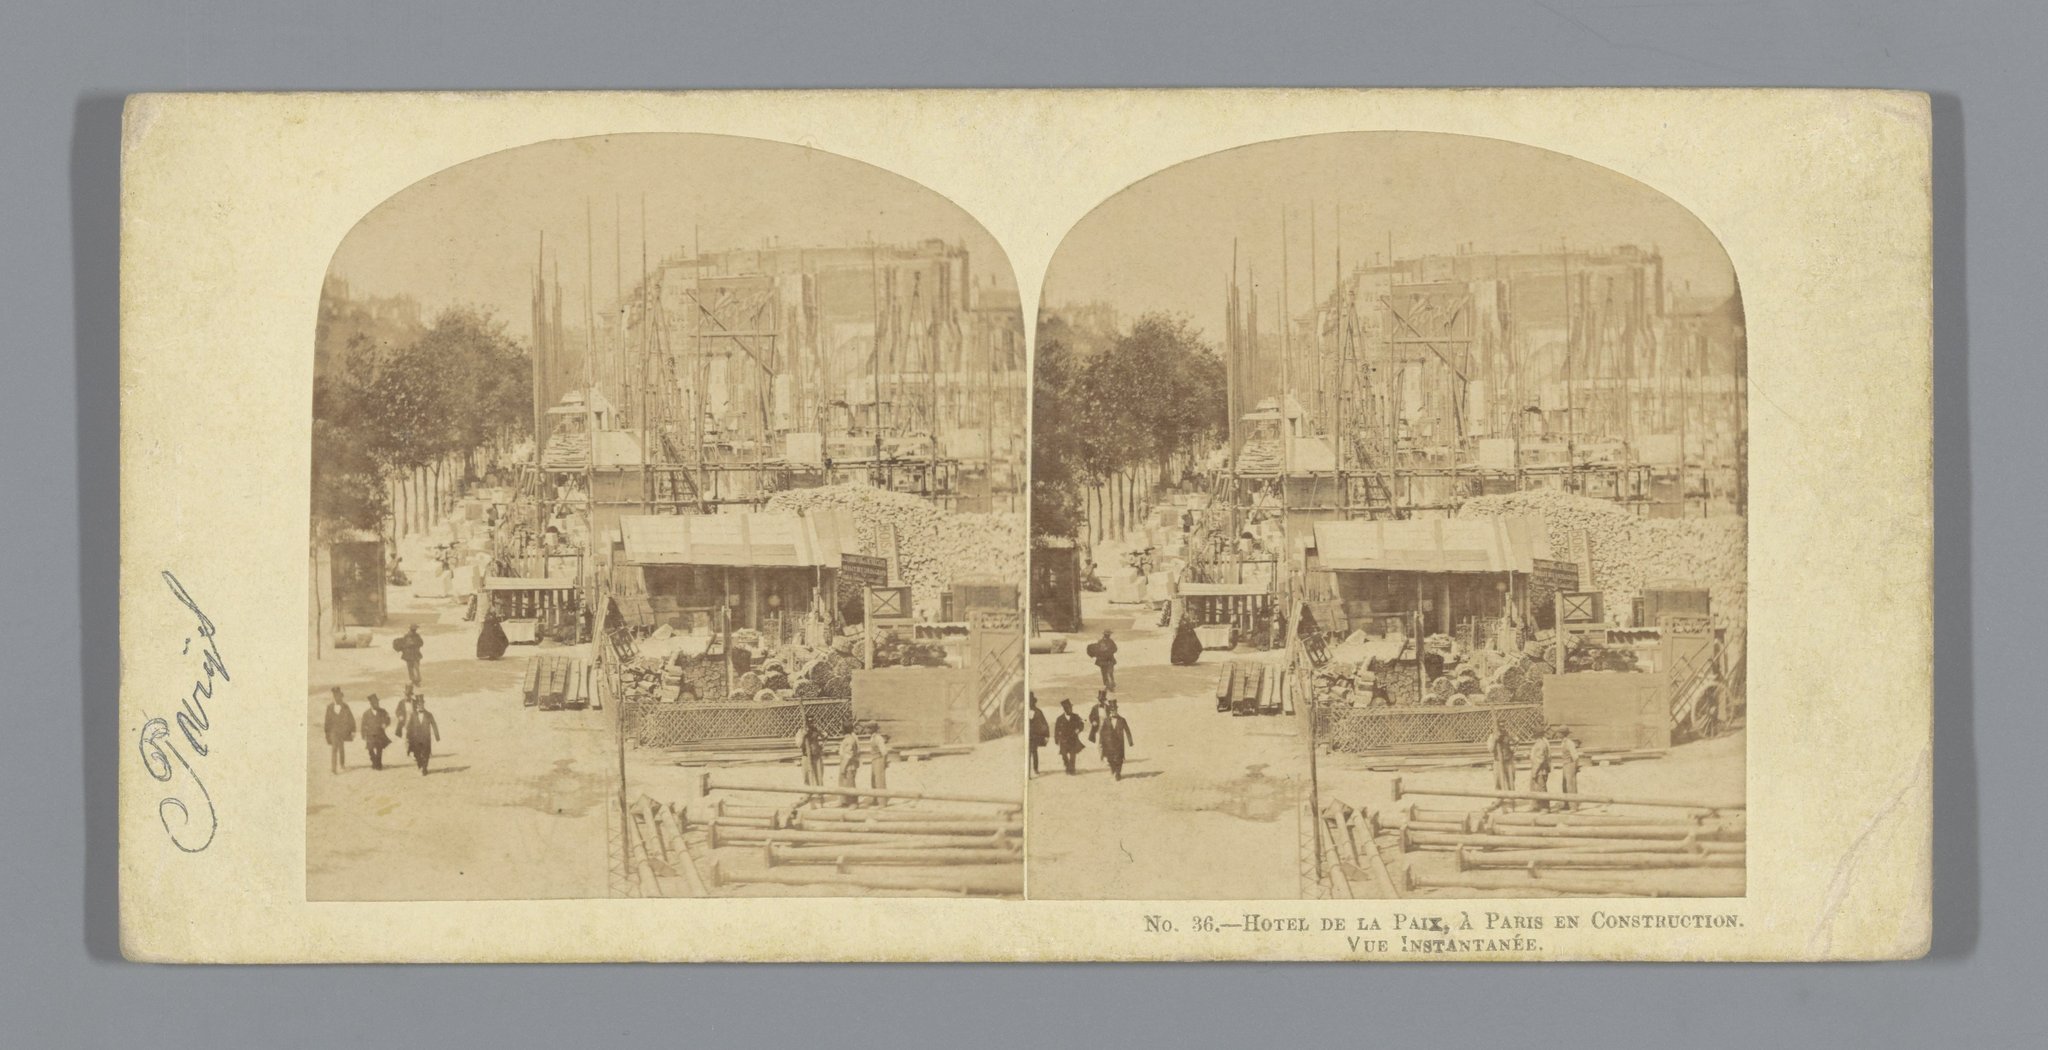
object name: stereograph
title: Gezicht op het Hotel De La Paix te Parijs in aanbouw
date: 1850-1875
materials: cardboard, photographic support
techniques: albumen print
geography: paris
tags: building-site, hotel, hostelry, inn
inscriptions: inscription: ‘Parijs’, number: ‘No. 36.’